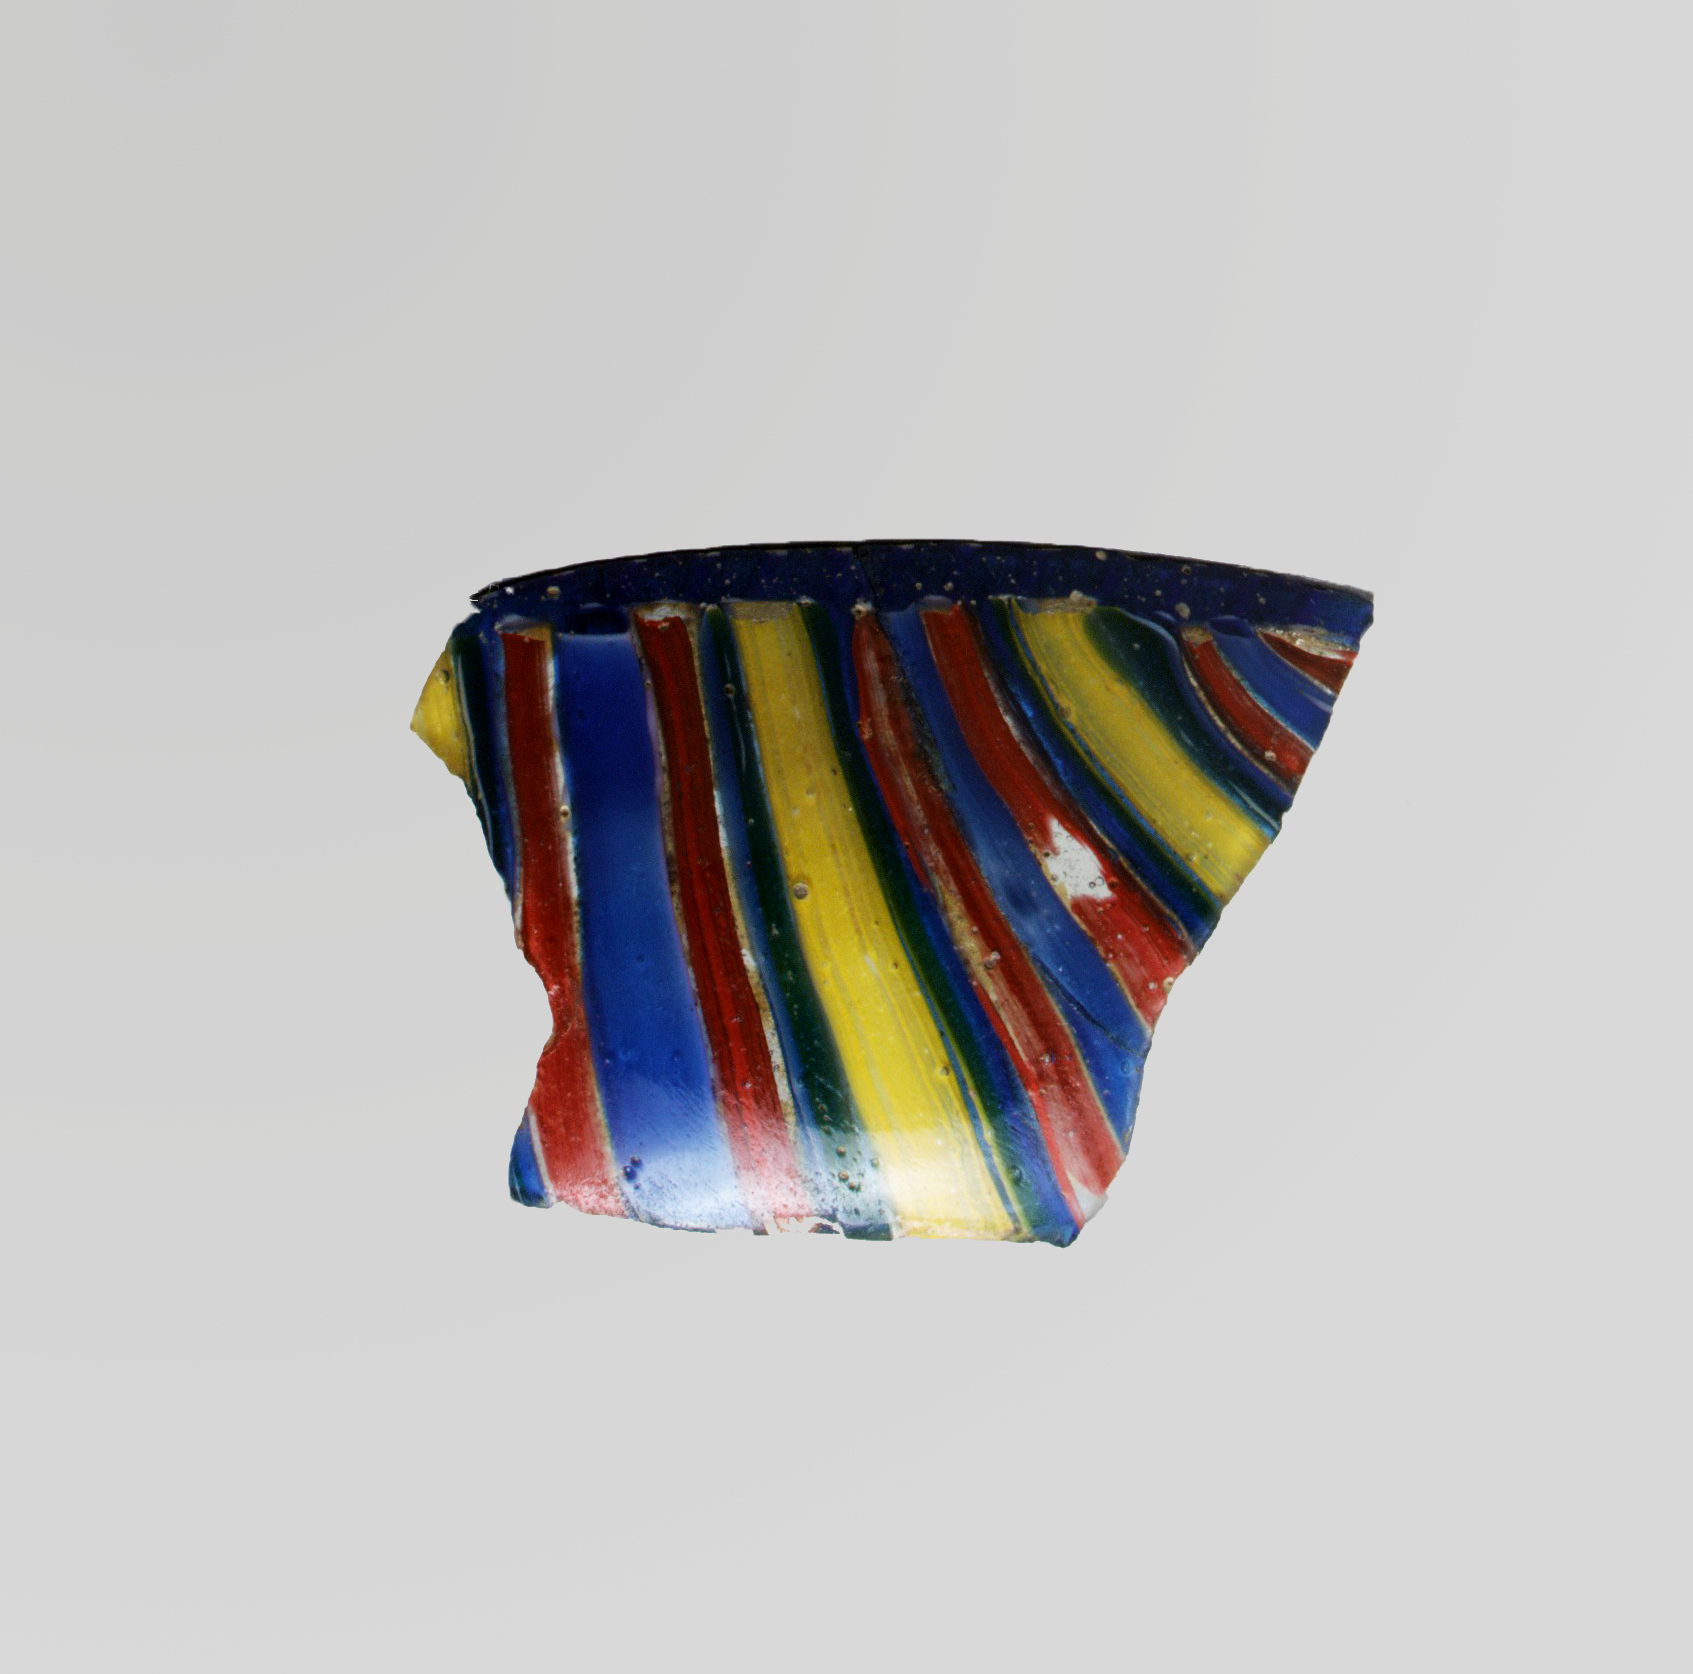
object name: fragment, striped mosaic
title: Glass striped mosaic bowl fragment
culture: roman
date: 34 BCE-33 CE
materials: glass